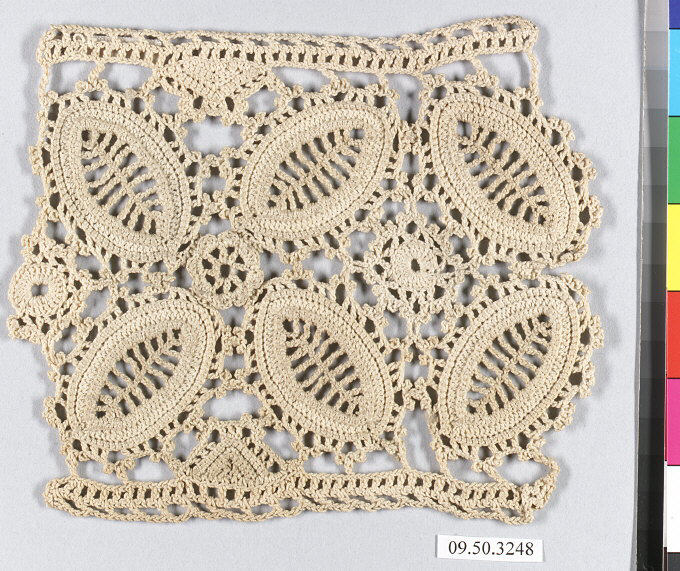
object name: sample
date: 1801-1900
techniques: crochet